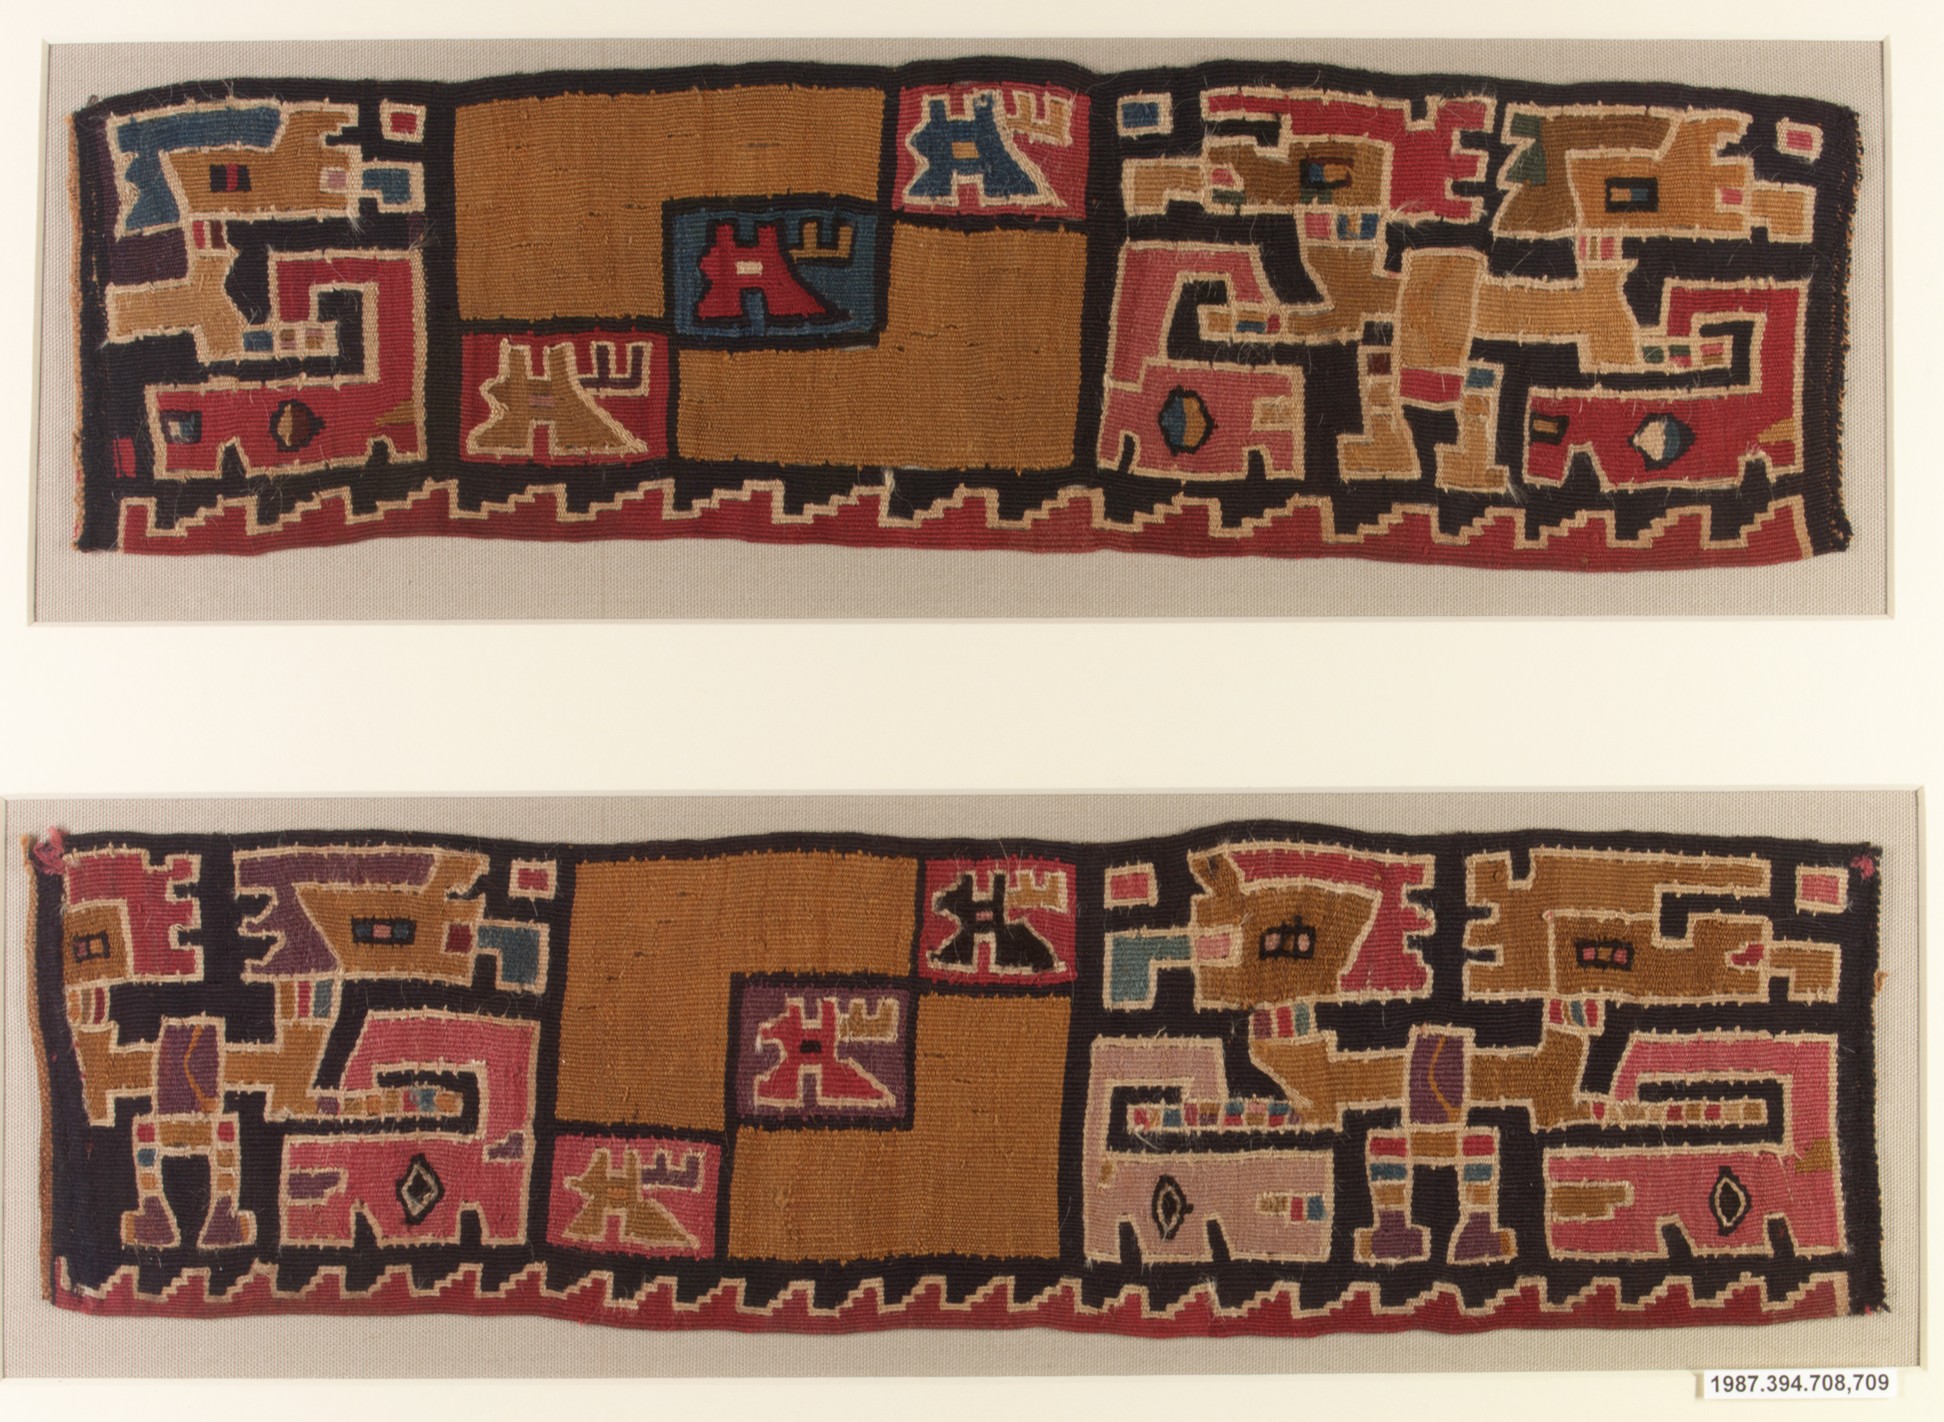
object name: cuff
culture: moche or wari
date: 601-800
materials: animal fiber, cotton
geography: peru